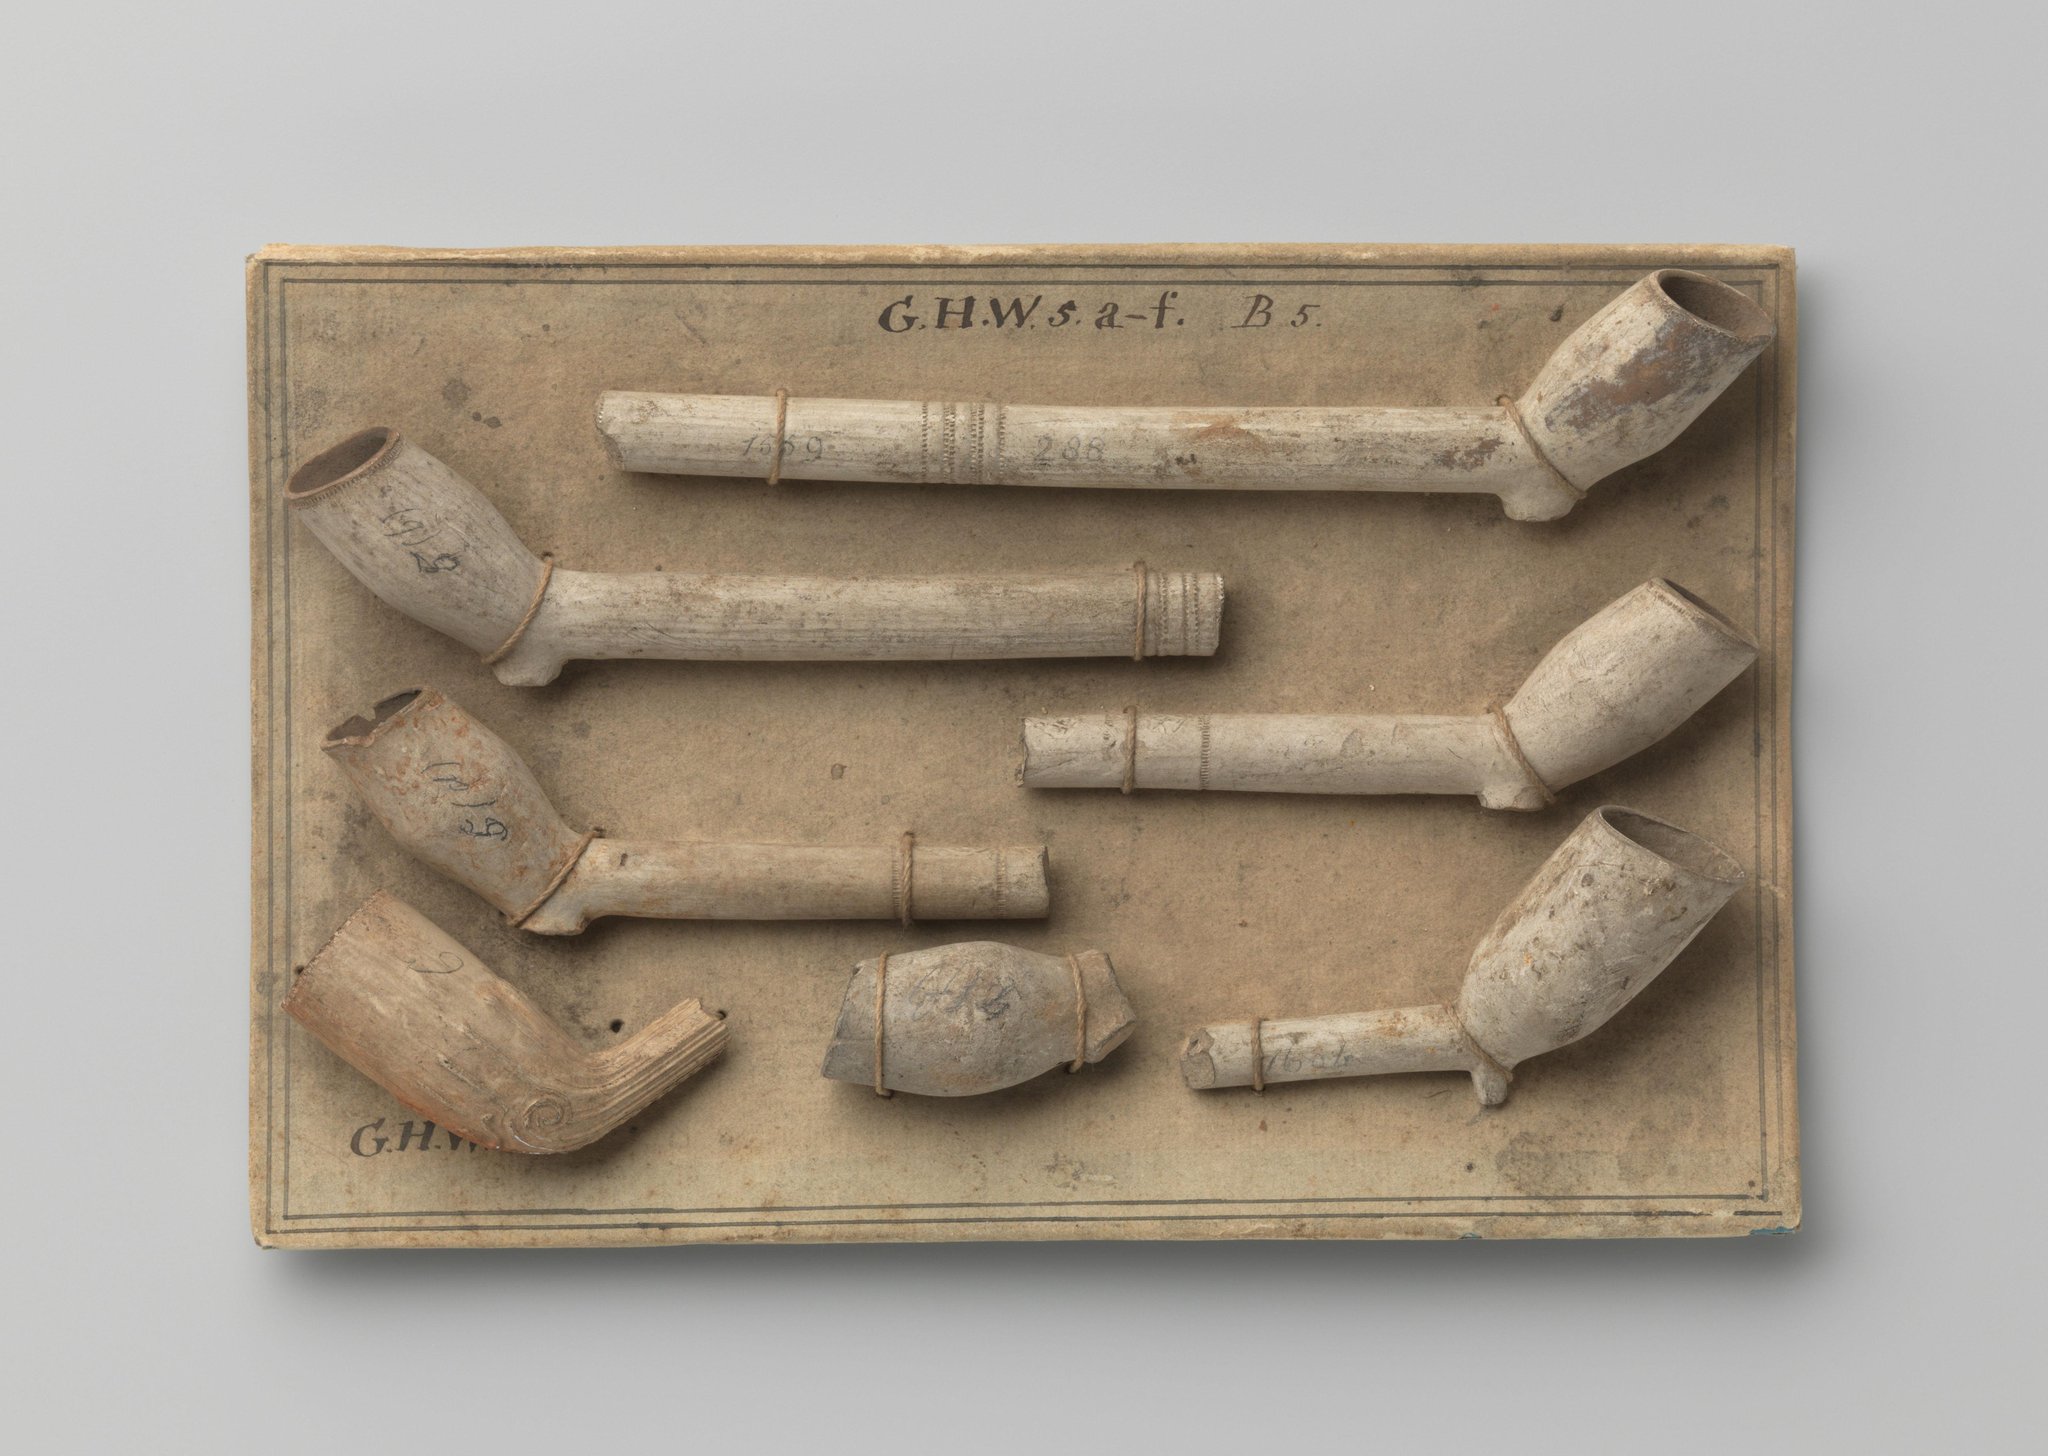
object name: pipe bowl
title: Pijpenkop van pijpaarde.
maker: Anonymous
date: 1600-1800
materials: earthenware, clay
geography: gouda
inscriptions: : ‘G.H.W.6’, : ‘G.H.W.5 a-f. 5B’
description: Pijpenkop van pijpaarde. De pijpenkop is onderdeel van een serie van zeven pijpenkoppen (BK-NM-6, BK-NM-5-1 t/m BK-NM-5-6), die op een karton, voorzien van een opschrift (G.H.W.5. en G.H.W.6: initialen van de oorspronkelijke verzamelaar Heinrich Gottfried Haasloop Werner (Kleef 16 april 1792-Elburg 29 september 1864), met volgnummers), zijn gemonteerd. Zes koppen hebben een deel van een steel, een kop heeft geen steel.